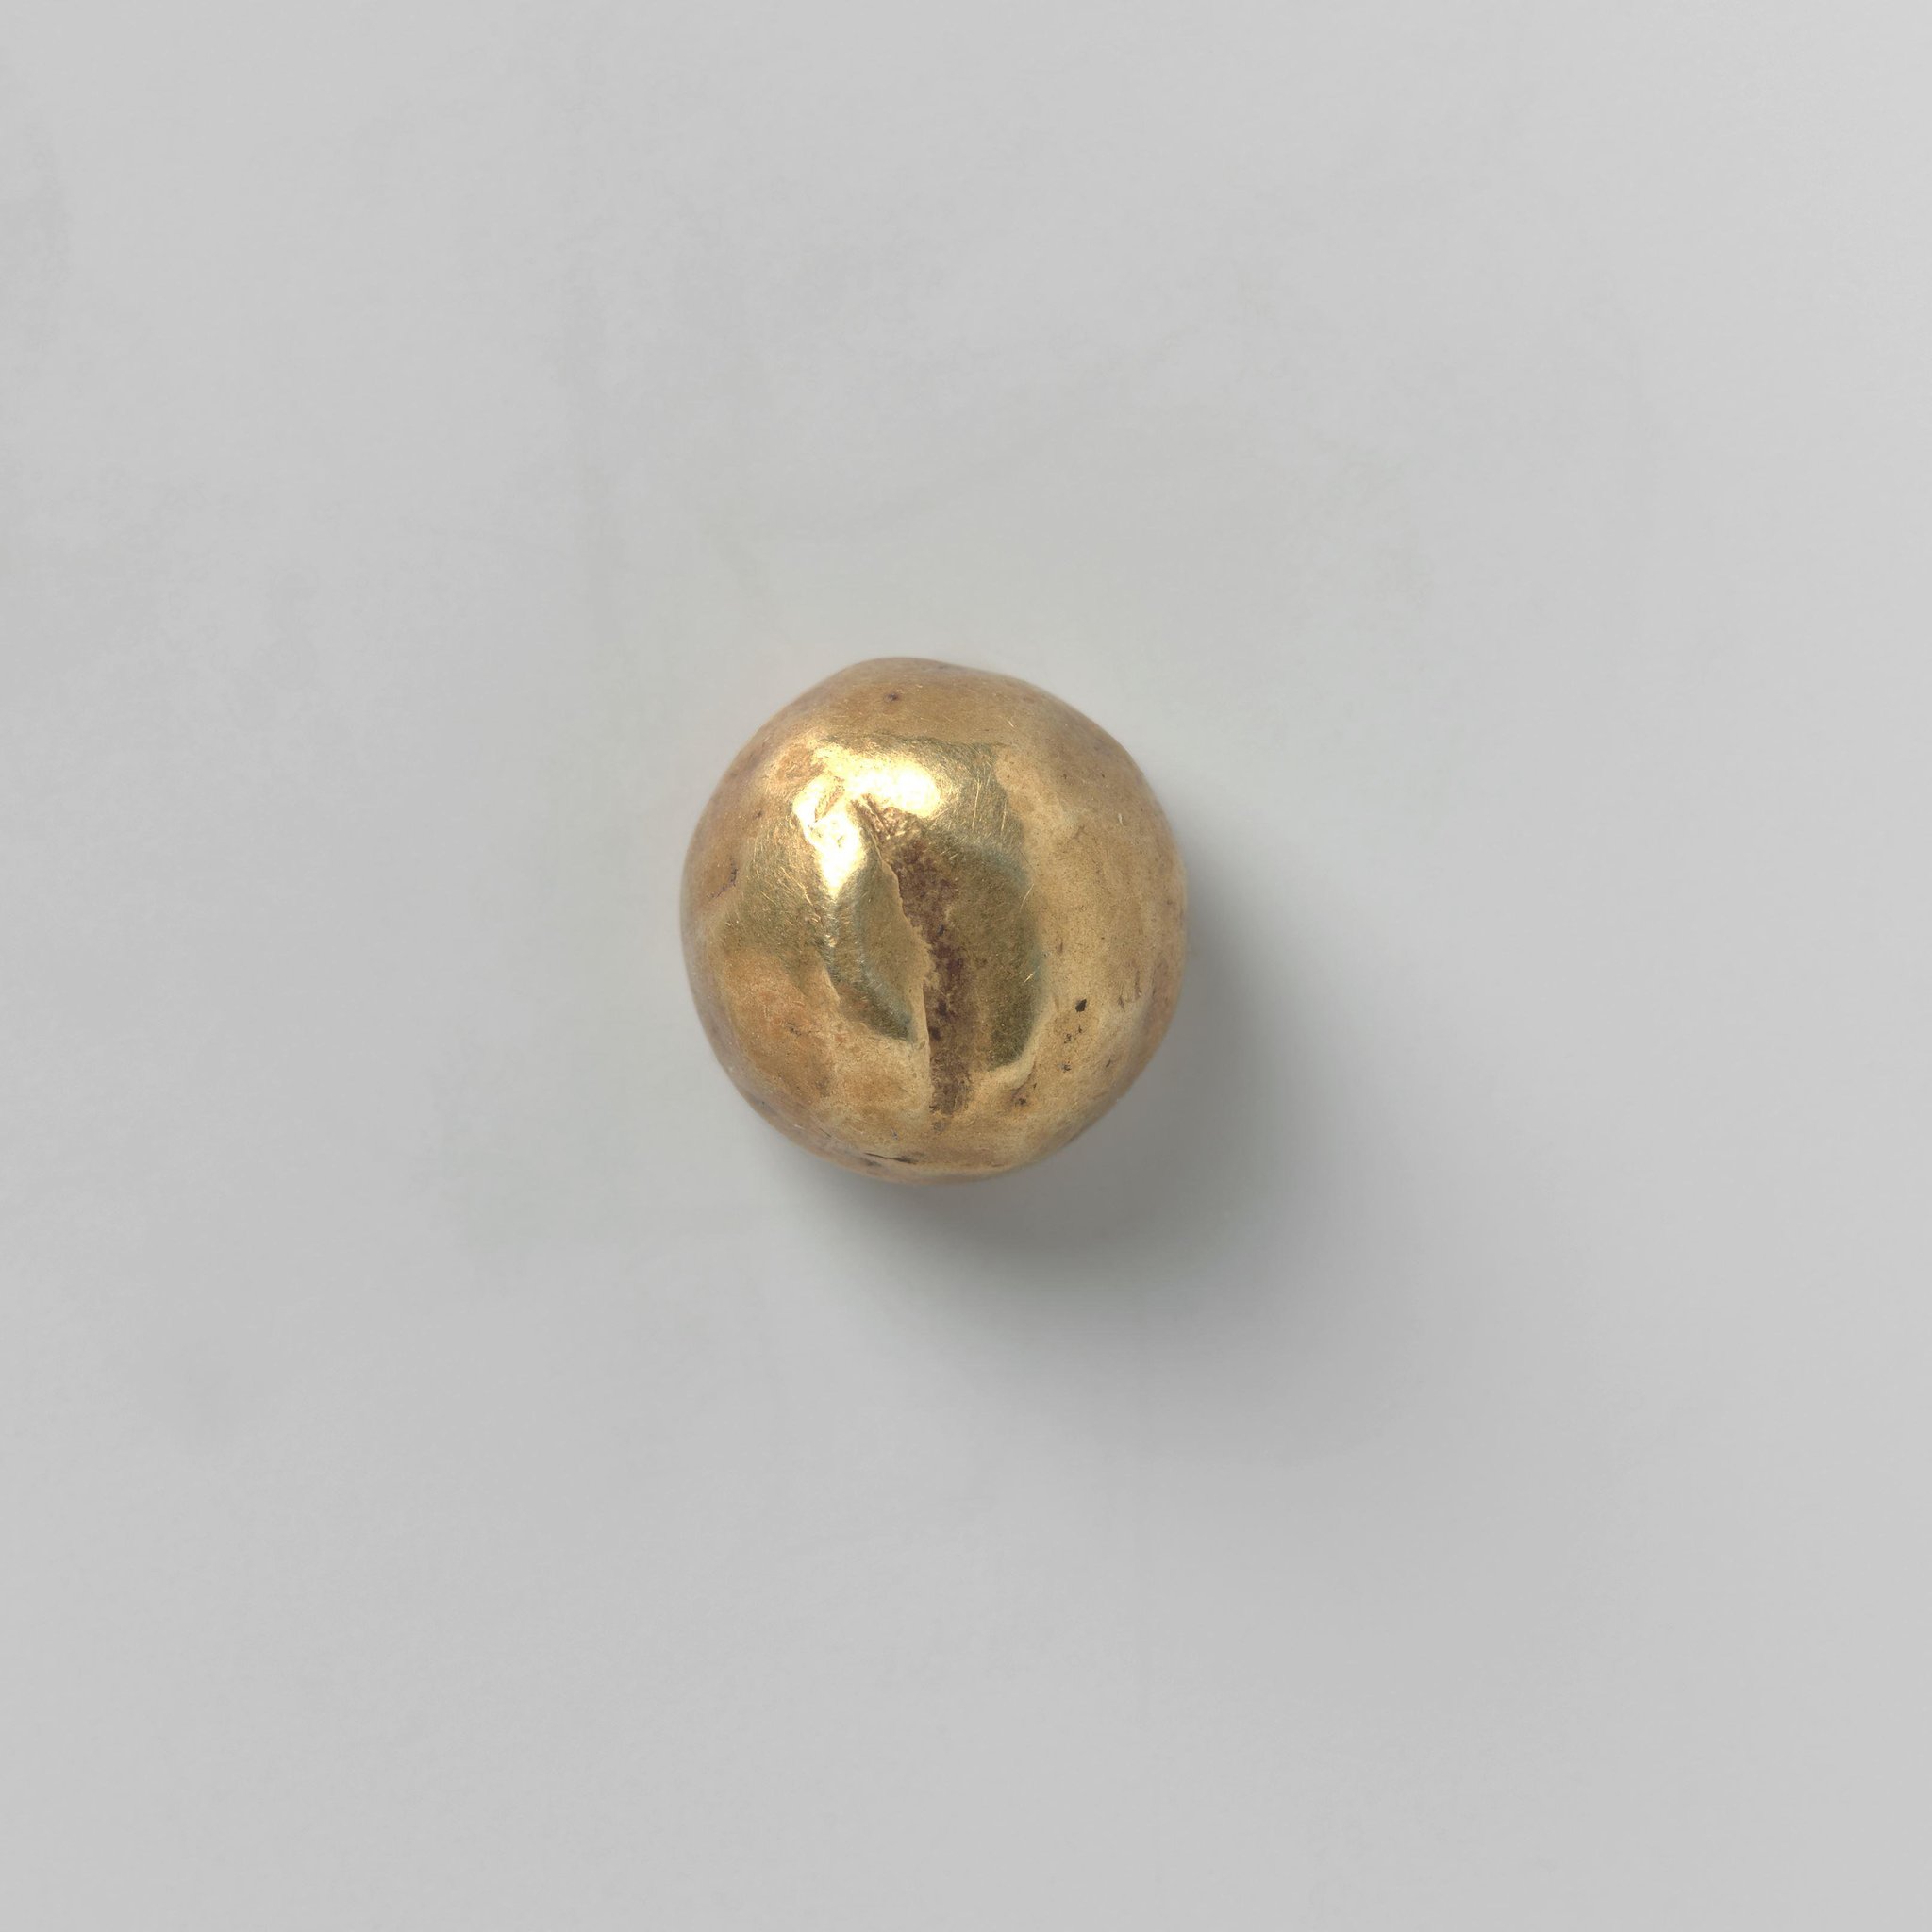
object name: massa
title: Soerakarta, Java, Tjaturwinsatimanam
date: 800-1200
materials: gold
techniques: striking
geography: java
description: Gouden bolvormige munt. Voorzijde: letterteken in devanagari-schrift [tja?]. Keerzijde, figuratie [bloem?].